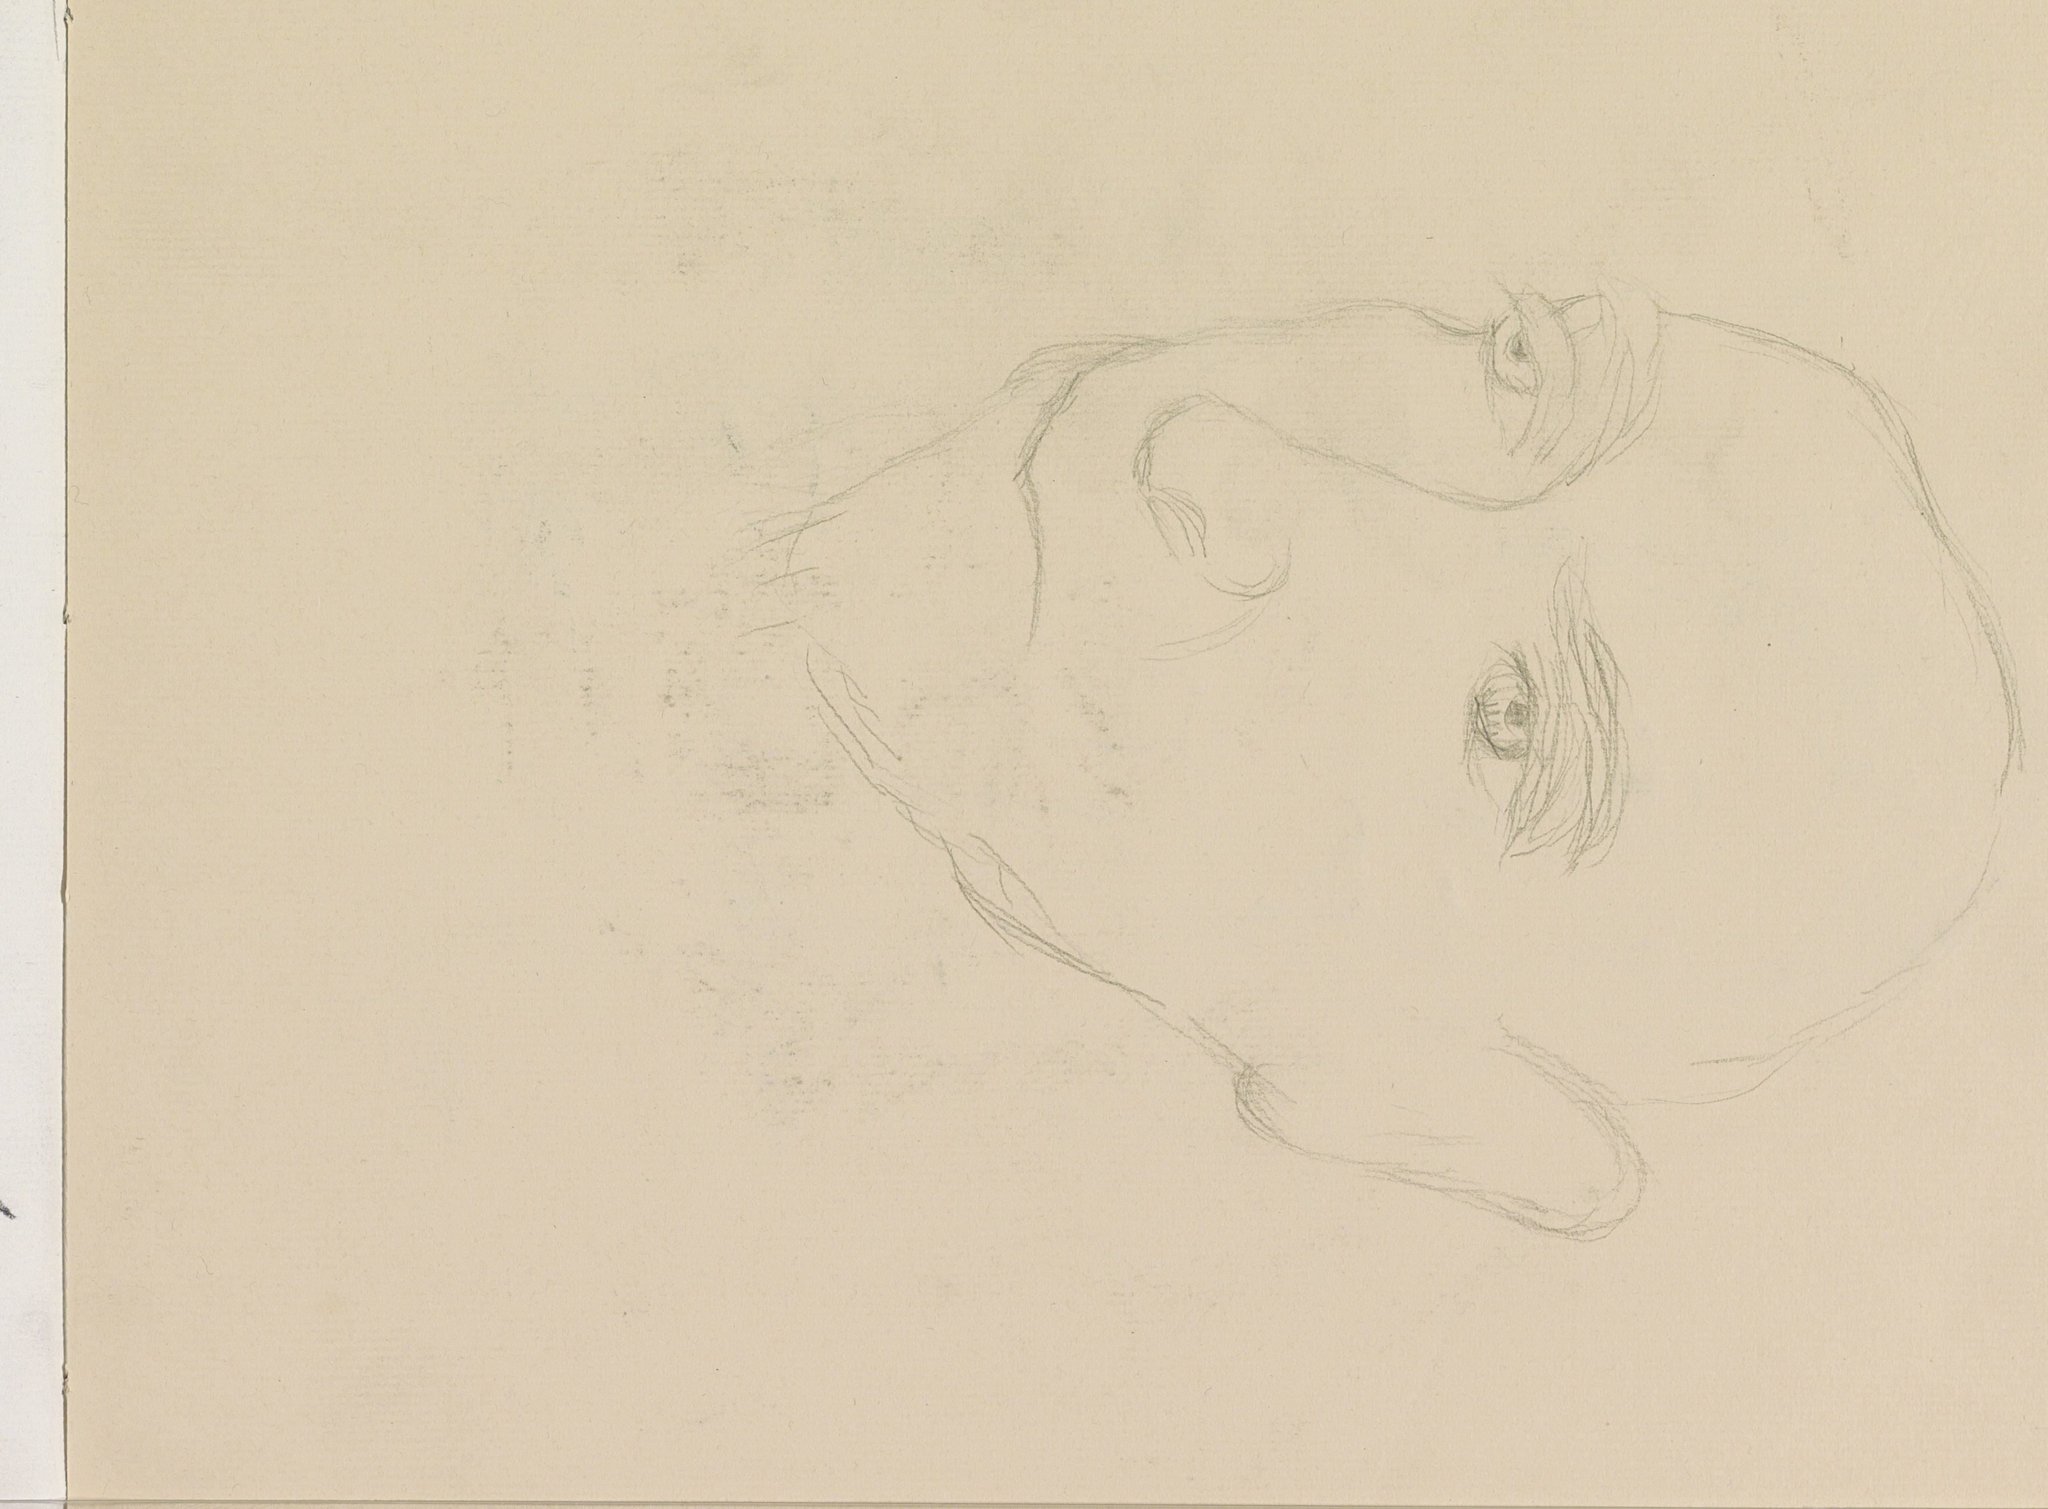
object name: sketchbook leaf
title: Mannengezicht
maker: isaac israels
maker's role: draughtsman, painter, print maker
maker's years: 1865-1934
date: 1875-1934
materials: paper, pencil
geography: the hague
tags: face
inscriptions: watermark: ‘VGZ’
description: Blad 16 recto uit schetsboek IV met 27 bladen.